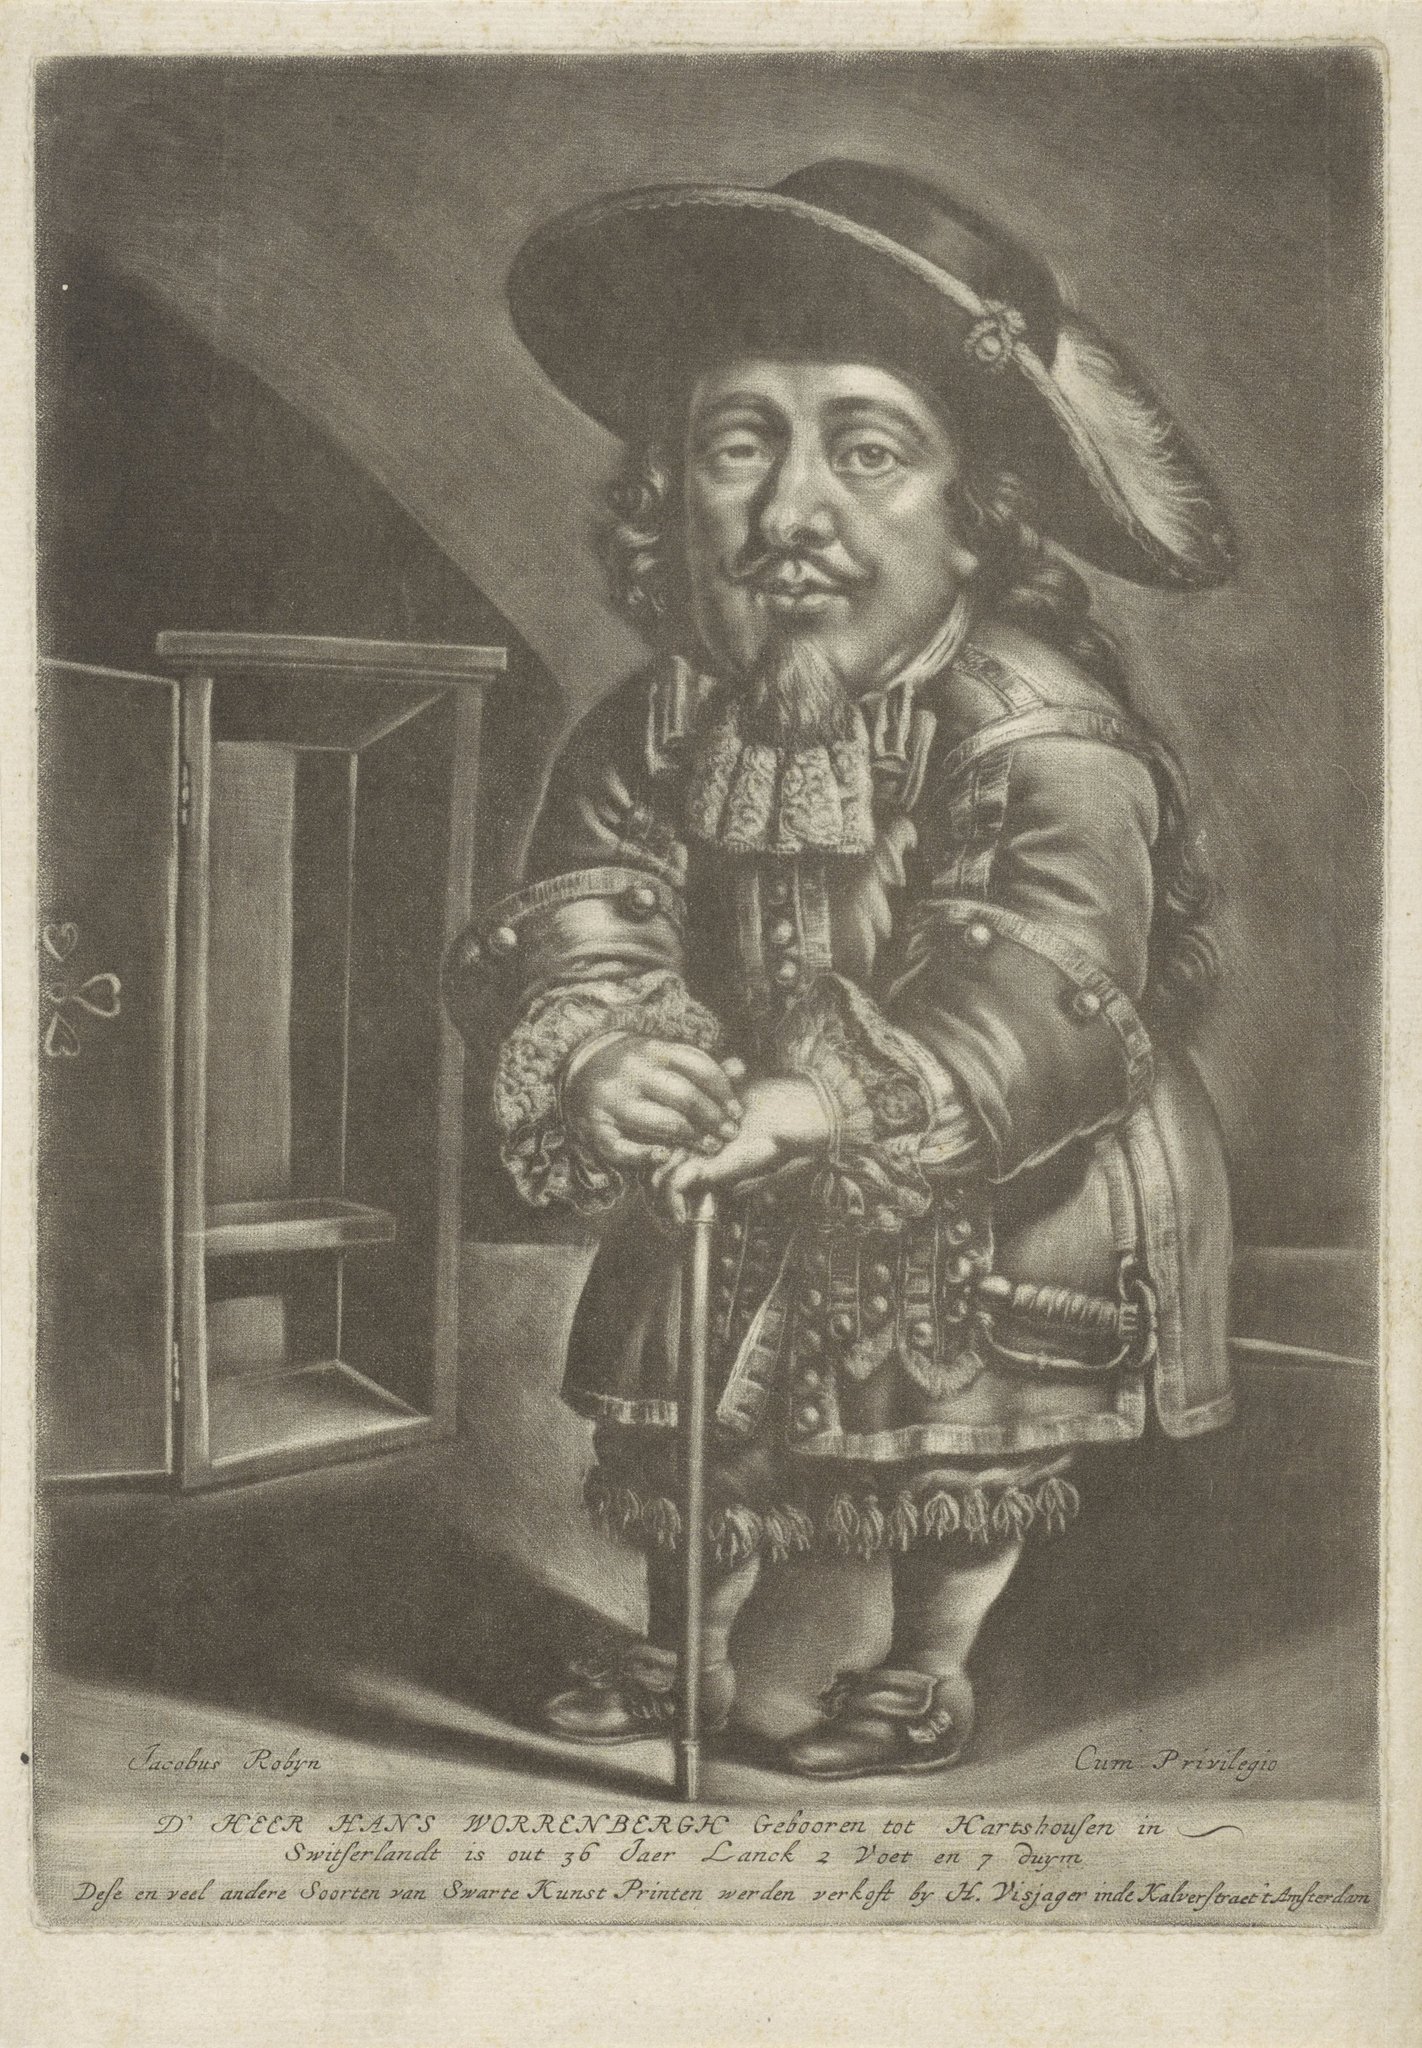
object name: print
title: Portret van Hans Worrenbergh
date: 1676-1700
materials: paper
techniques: mezzotint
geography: amsterdam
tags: little people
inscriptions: collector's mark: Lugt 2228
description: De Zwitserse kleine mens Hans Worrenbergh op 36-jarige leeftijd. Hij leunt op zijn stok. In de marge zijn naam, geboorteplaats, leeftijd en zijn lengte.